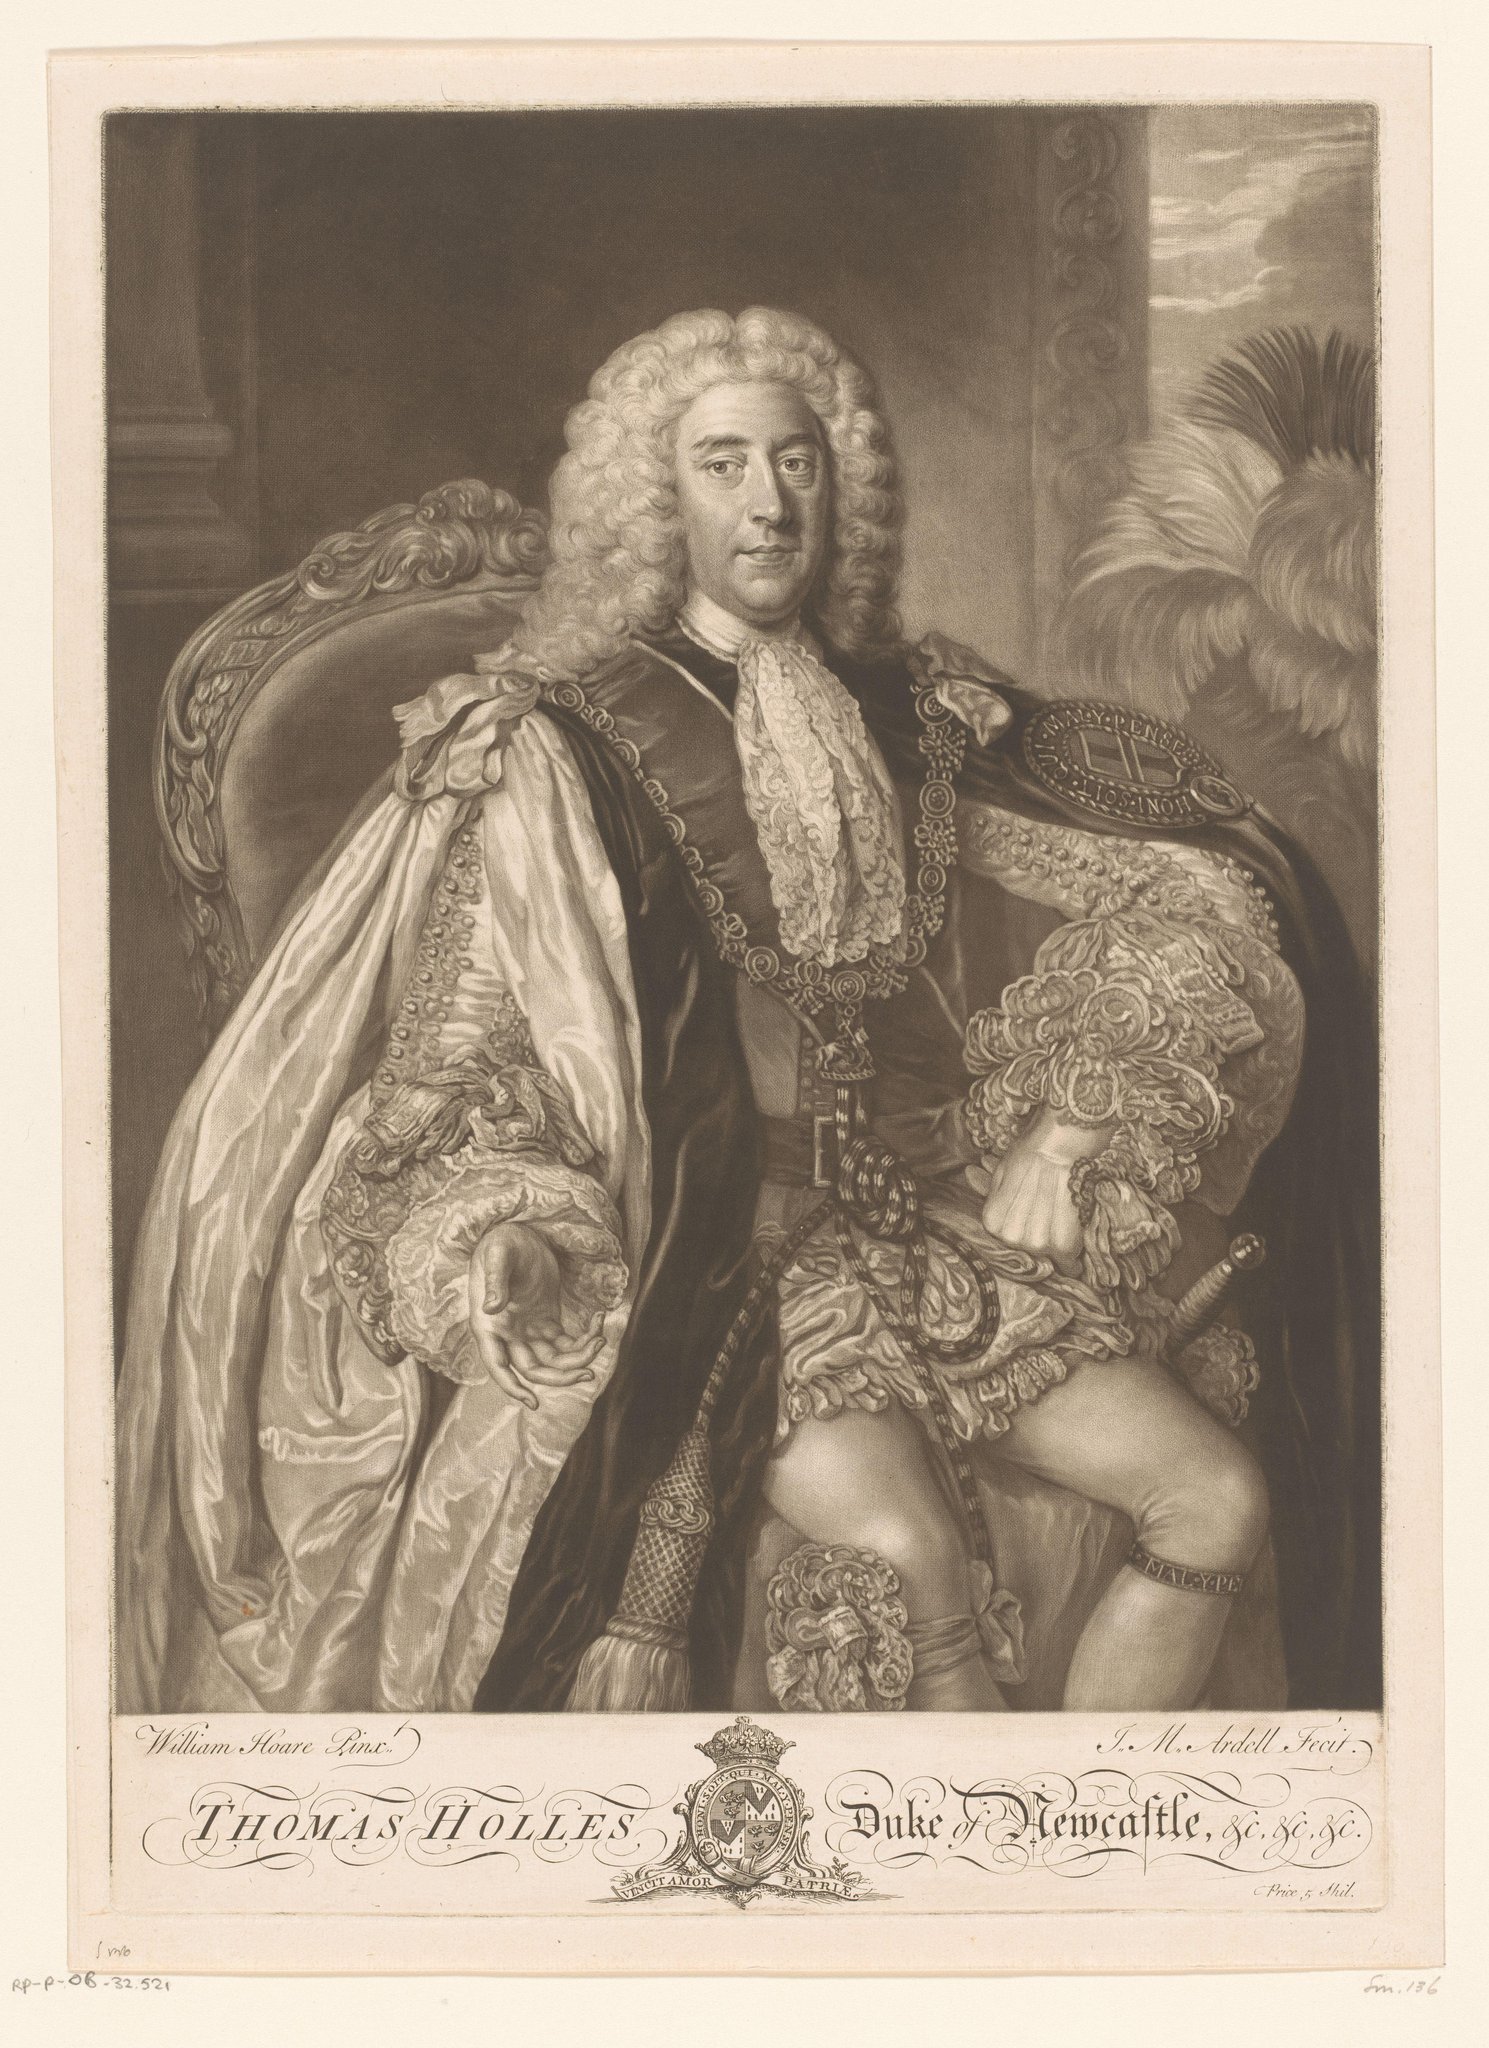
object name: print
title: Thomas Holles Duke of Newcastle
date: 1745-1765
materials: paper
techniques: mezzotint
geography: london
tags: london, historical persons, politician, e.g. party leader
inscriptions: collector's mark: Lugt 240